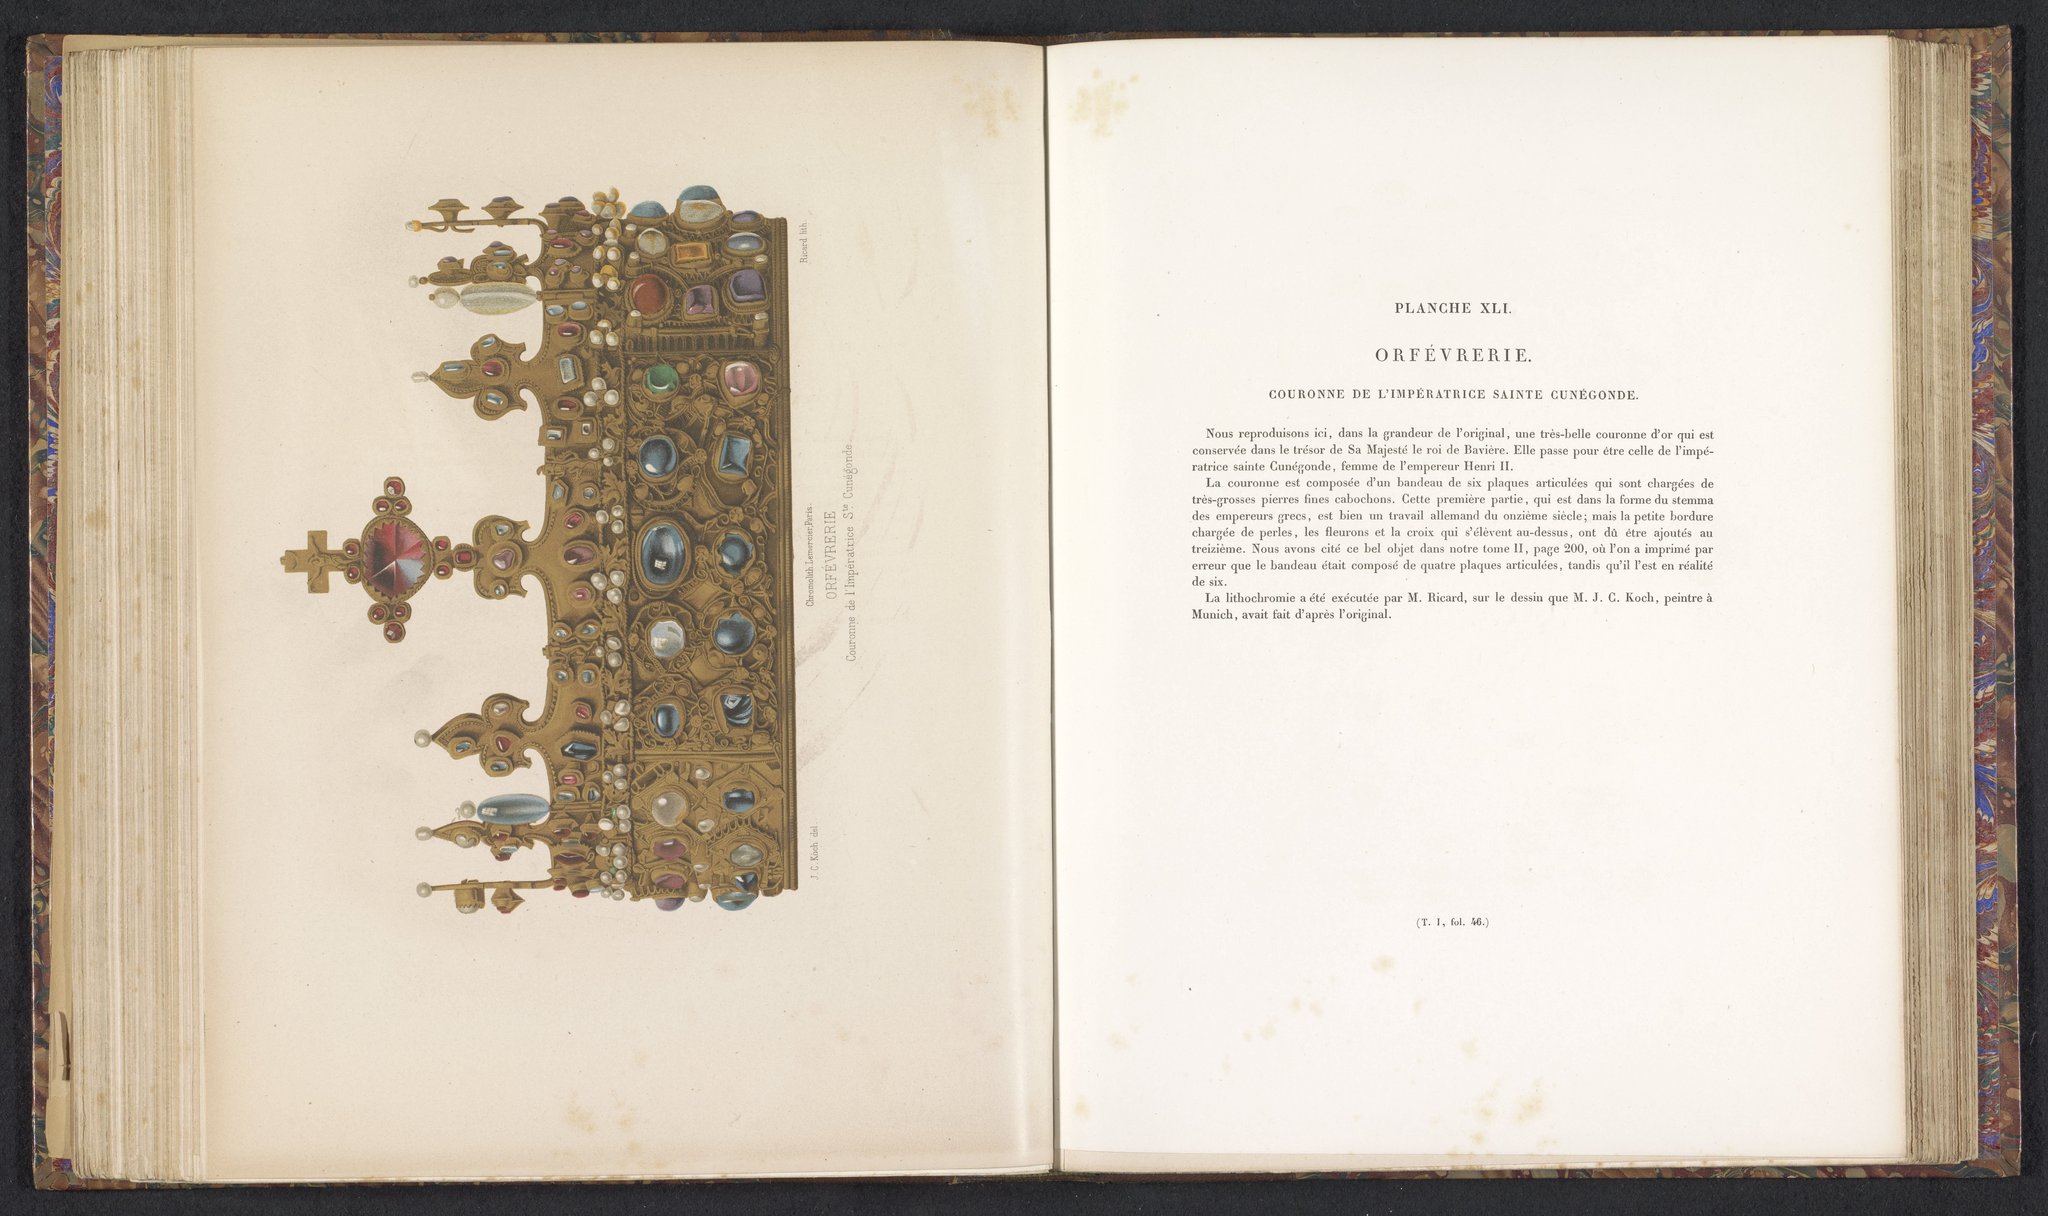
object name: print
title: Couronne de l'Impératrice Ste. Cunegonde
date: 1859-1864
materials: paper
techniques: chromolithography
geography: paris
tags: crown (symbol of sovereignty)